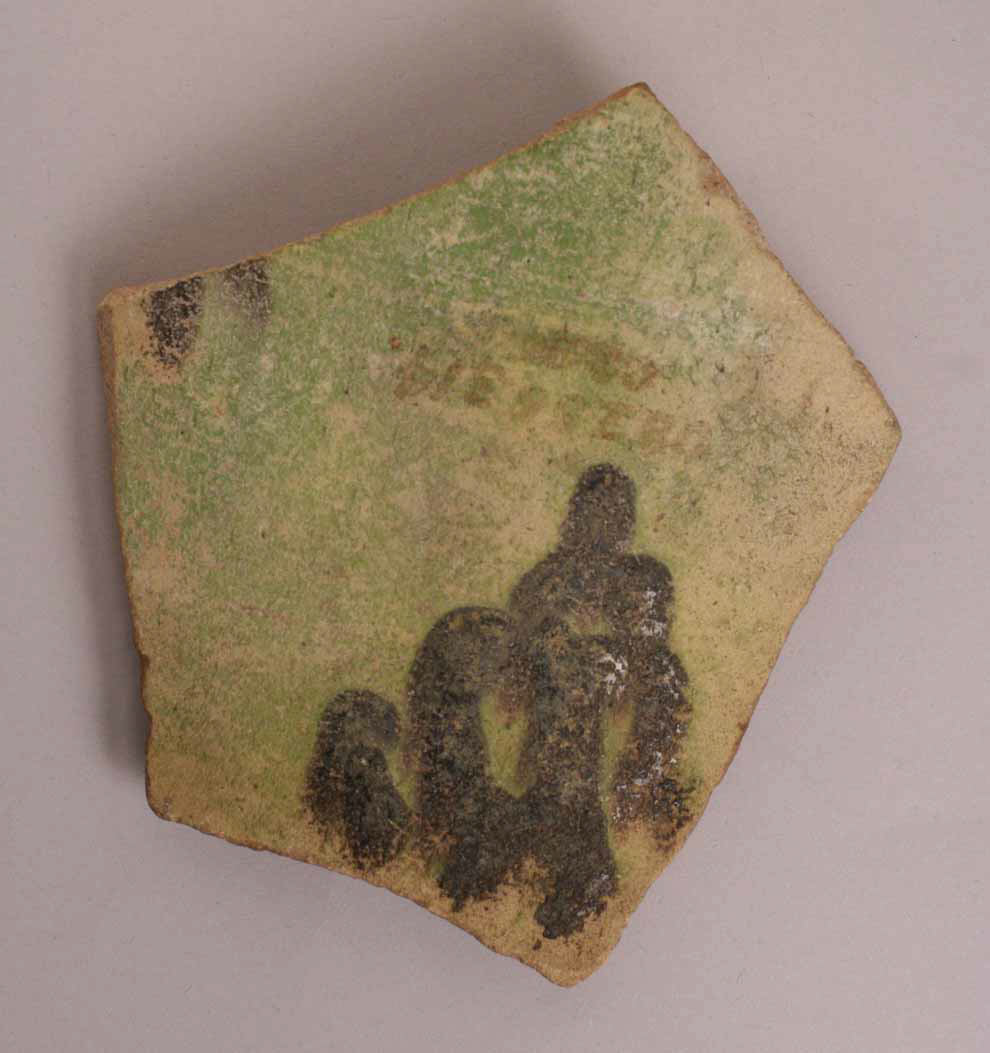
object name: ceramic fragment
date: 901-1200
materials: earthenware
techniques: painting, underglaze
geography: egypt